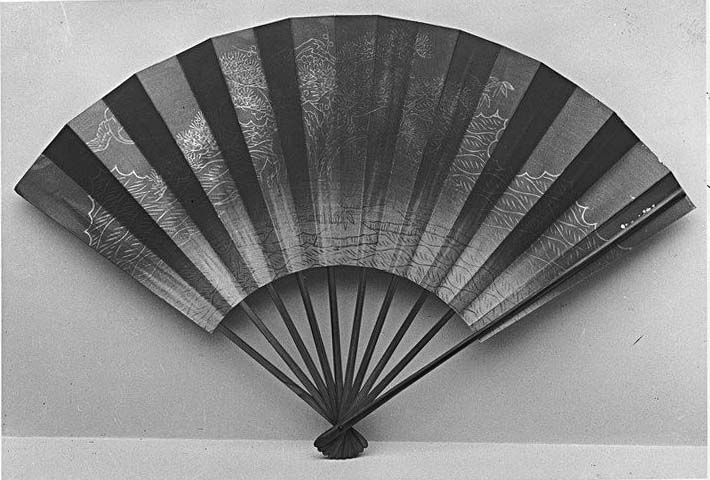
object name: folding fan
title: Fan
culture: japanese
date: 1901-2000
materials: metal, paint, paper